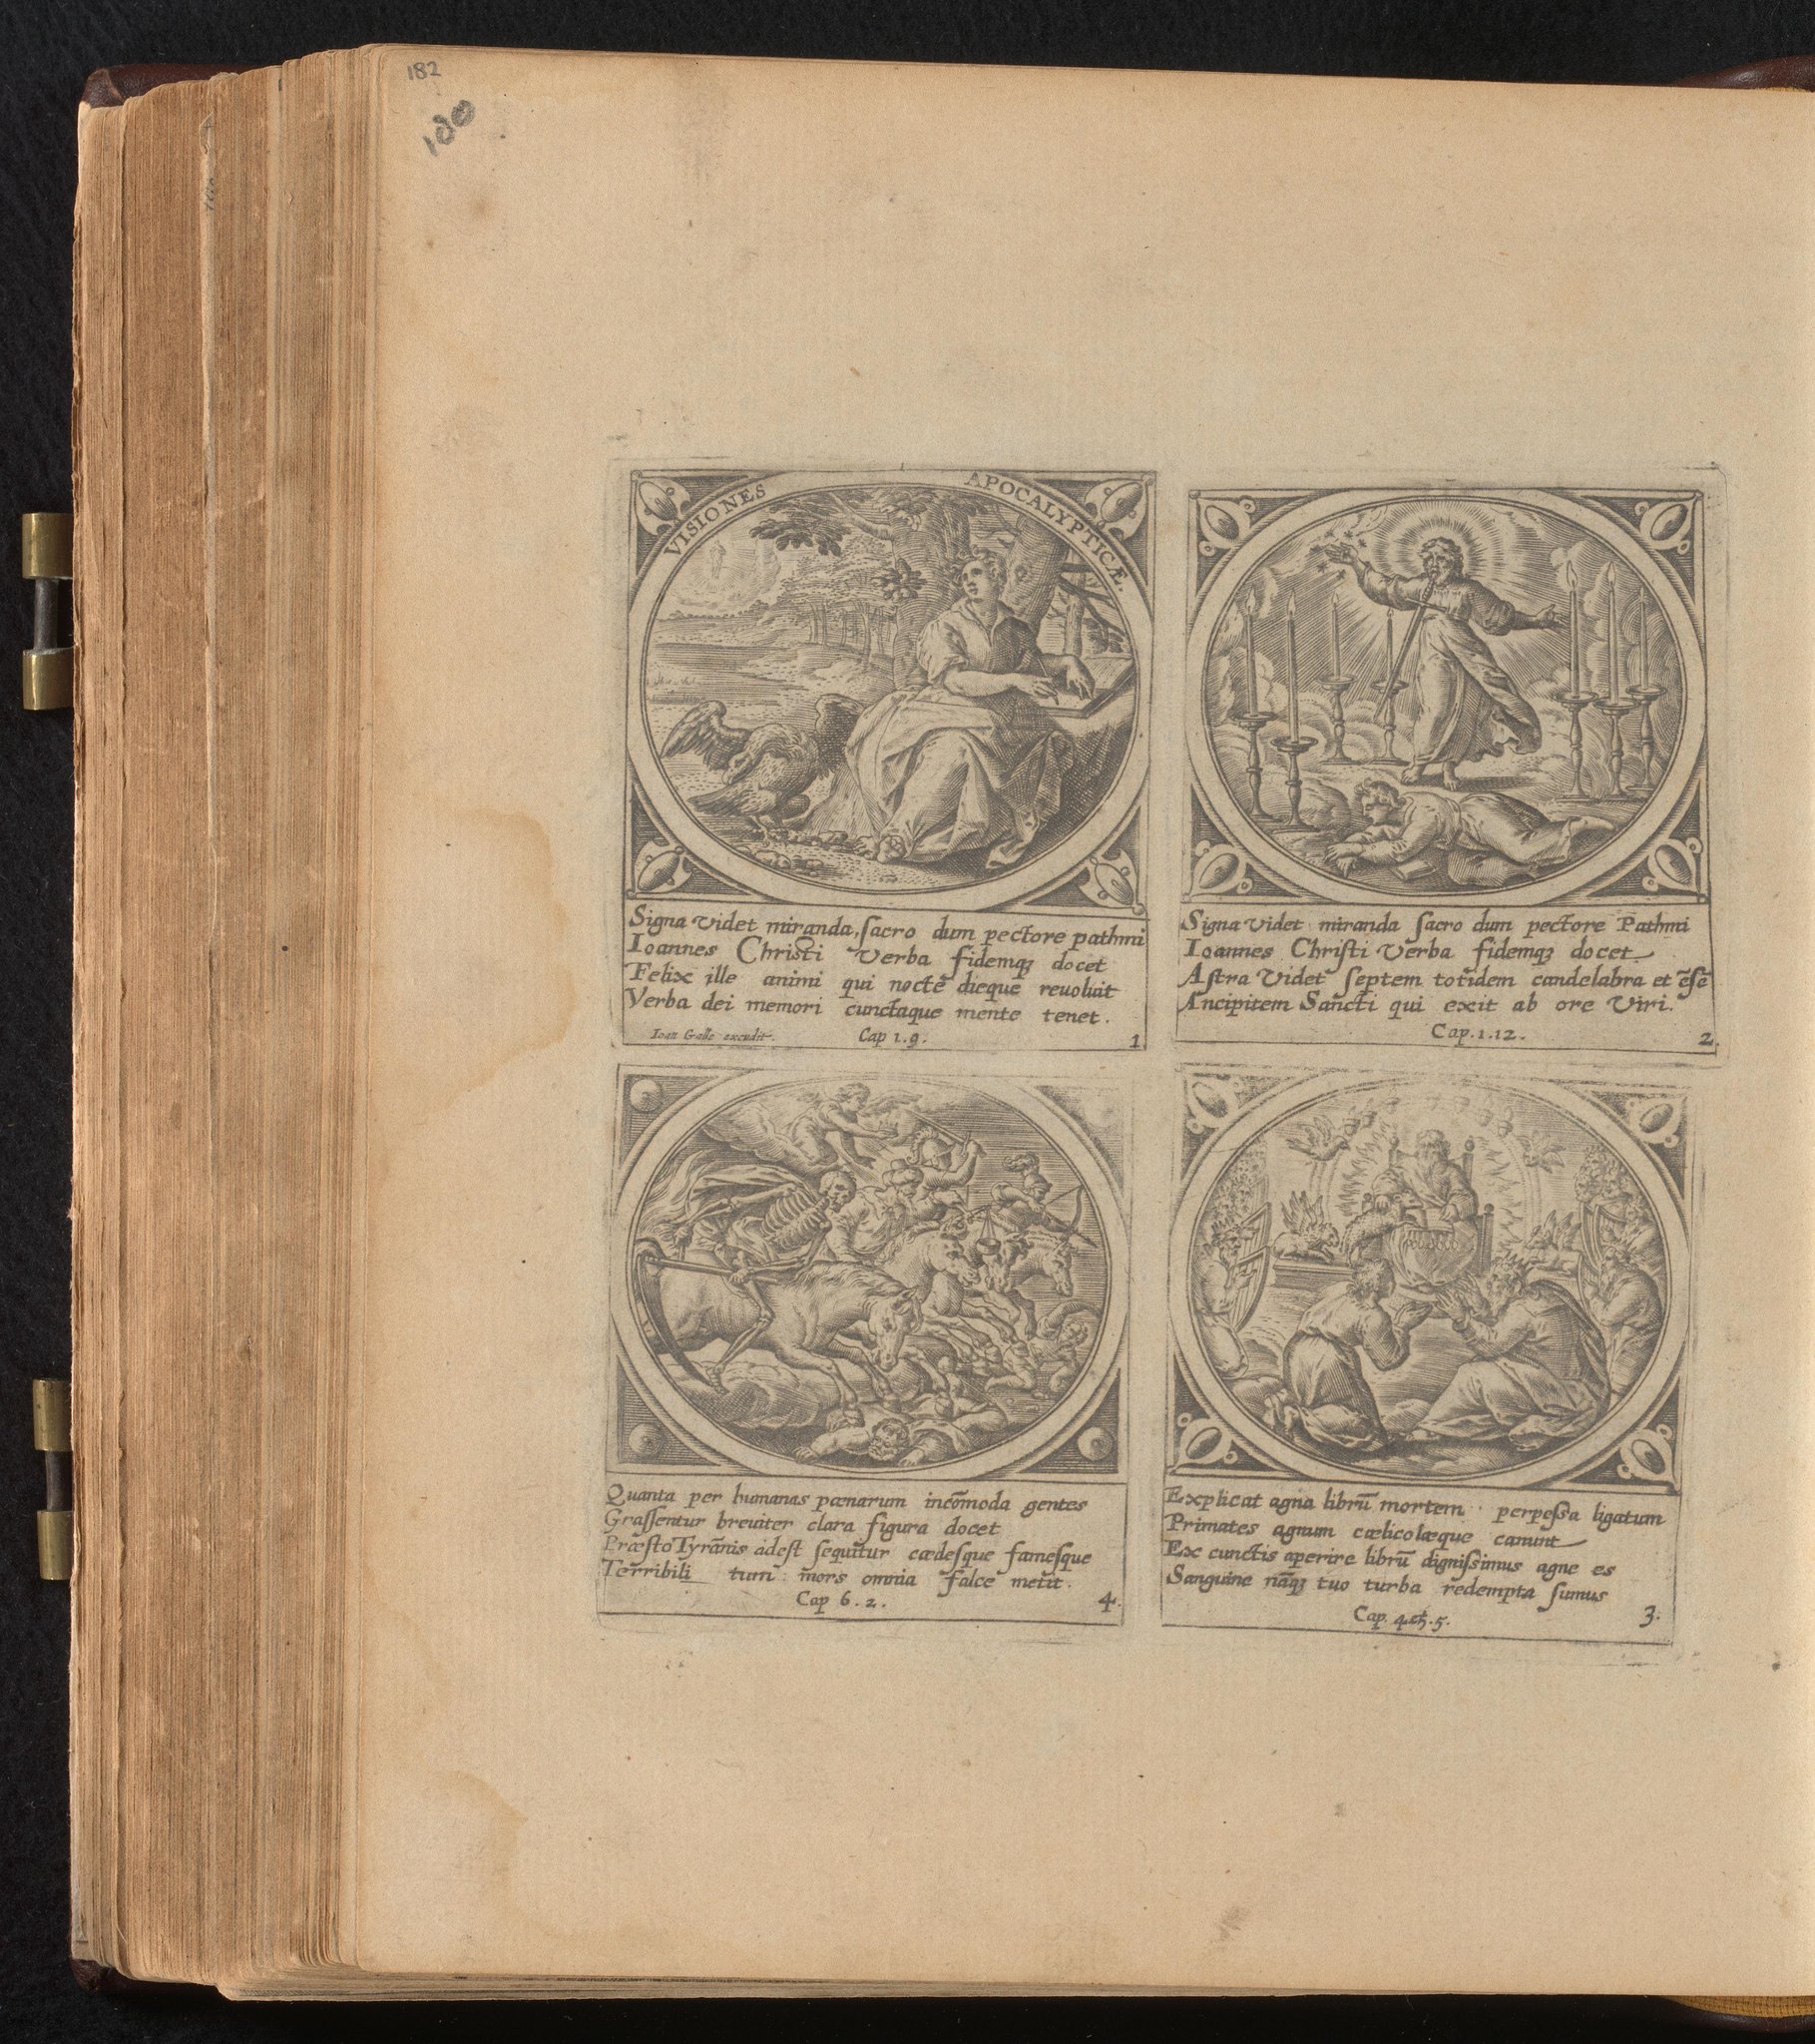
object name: album leaf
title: Visoenen van Johannes de Evangelist op Patmos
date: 1585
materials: paper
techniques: engraving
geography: antwerp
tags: christ between seven golden candlesticks appears to john, who falls to the ground; a sword comes out of christ's mouth and he holds seven stars in his hands, the four horsemen of the apocalypse, an angel sent by christ appears to john on patmos, the throne of god ~ revelation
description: Onversneden blad met vier prenten uit dezelfde serie, rechtsonder genummerd van 1 tot en met 4. Prenten maken deel uit van een prentbijbel.